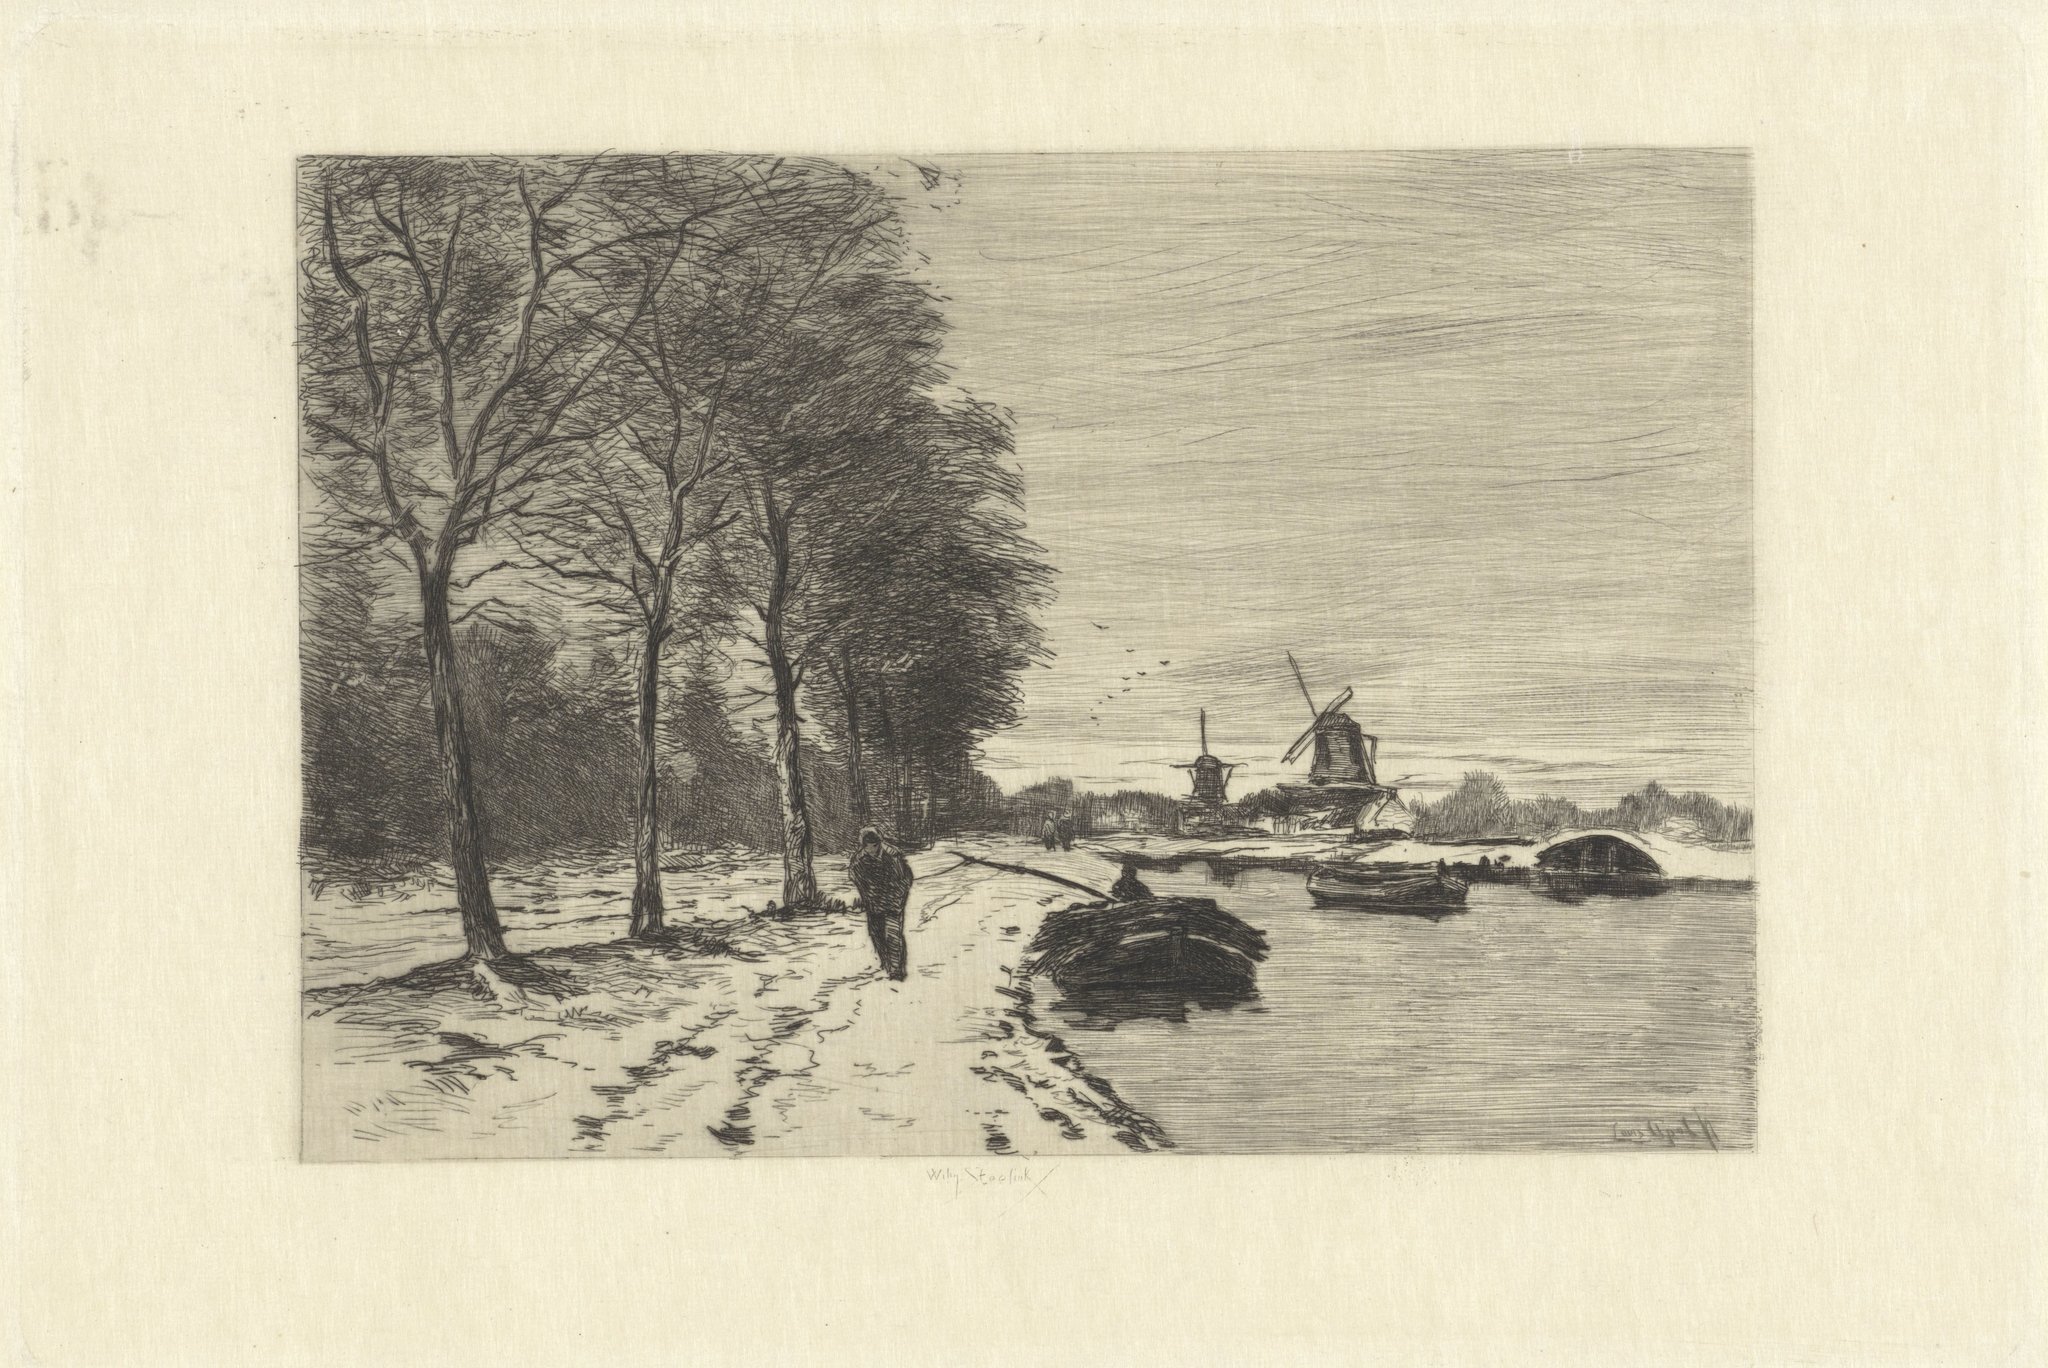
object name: print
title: Winterlandschap met vaart en molens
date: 1889-1897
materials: paper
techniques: etching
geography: netherlands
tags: canal, winter landscape; landscape symbolizing winter (the four seasons of the year), windmill in landscape, snow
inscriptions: collector's mark: Lugt 2228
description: Over een besneeuwd pad langs een vaart loopt een man. Op de achtergrond twee molens.